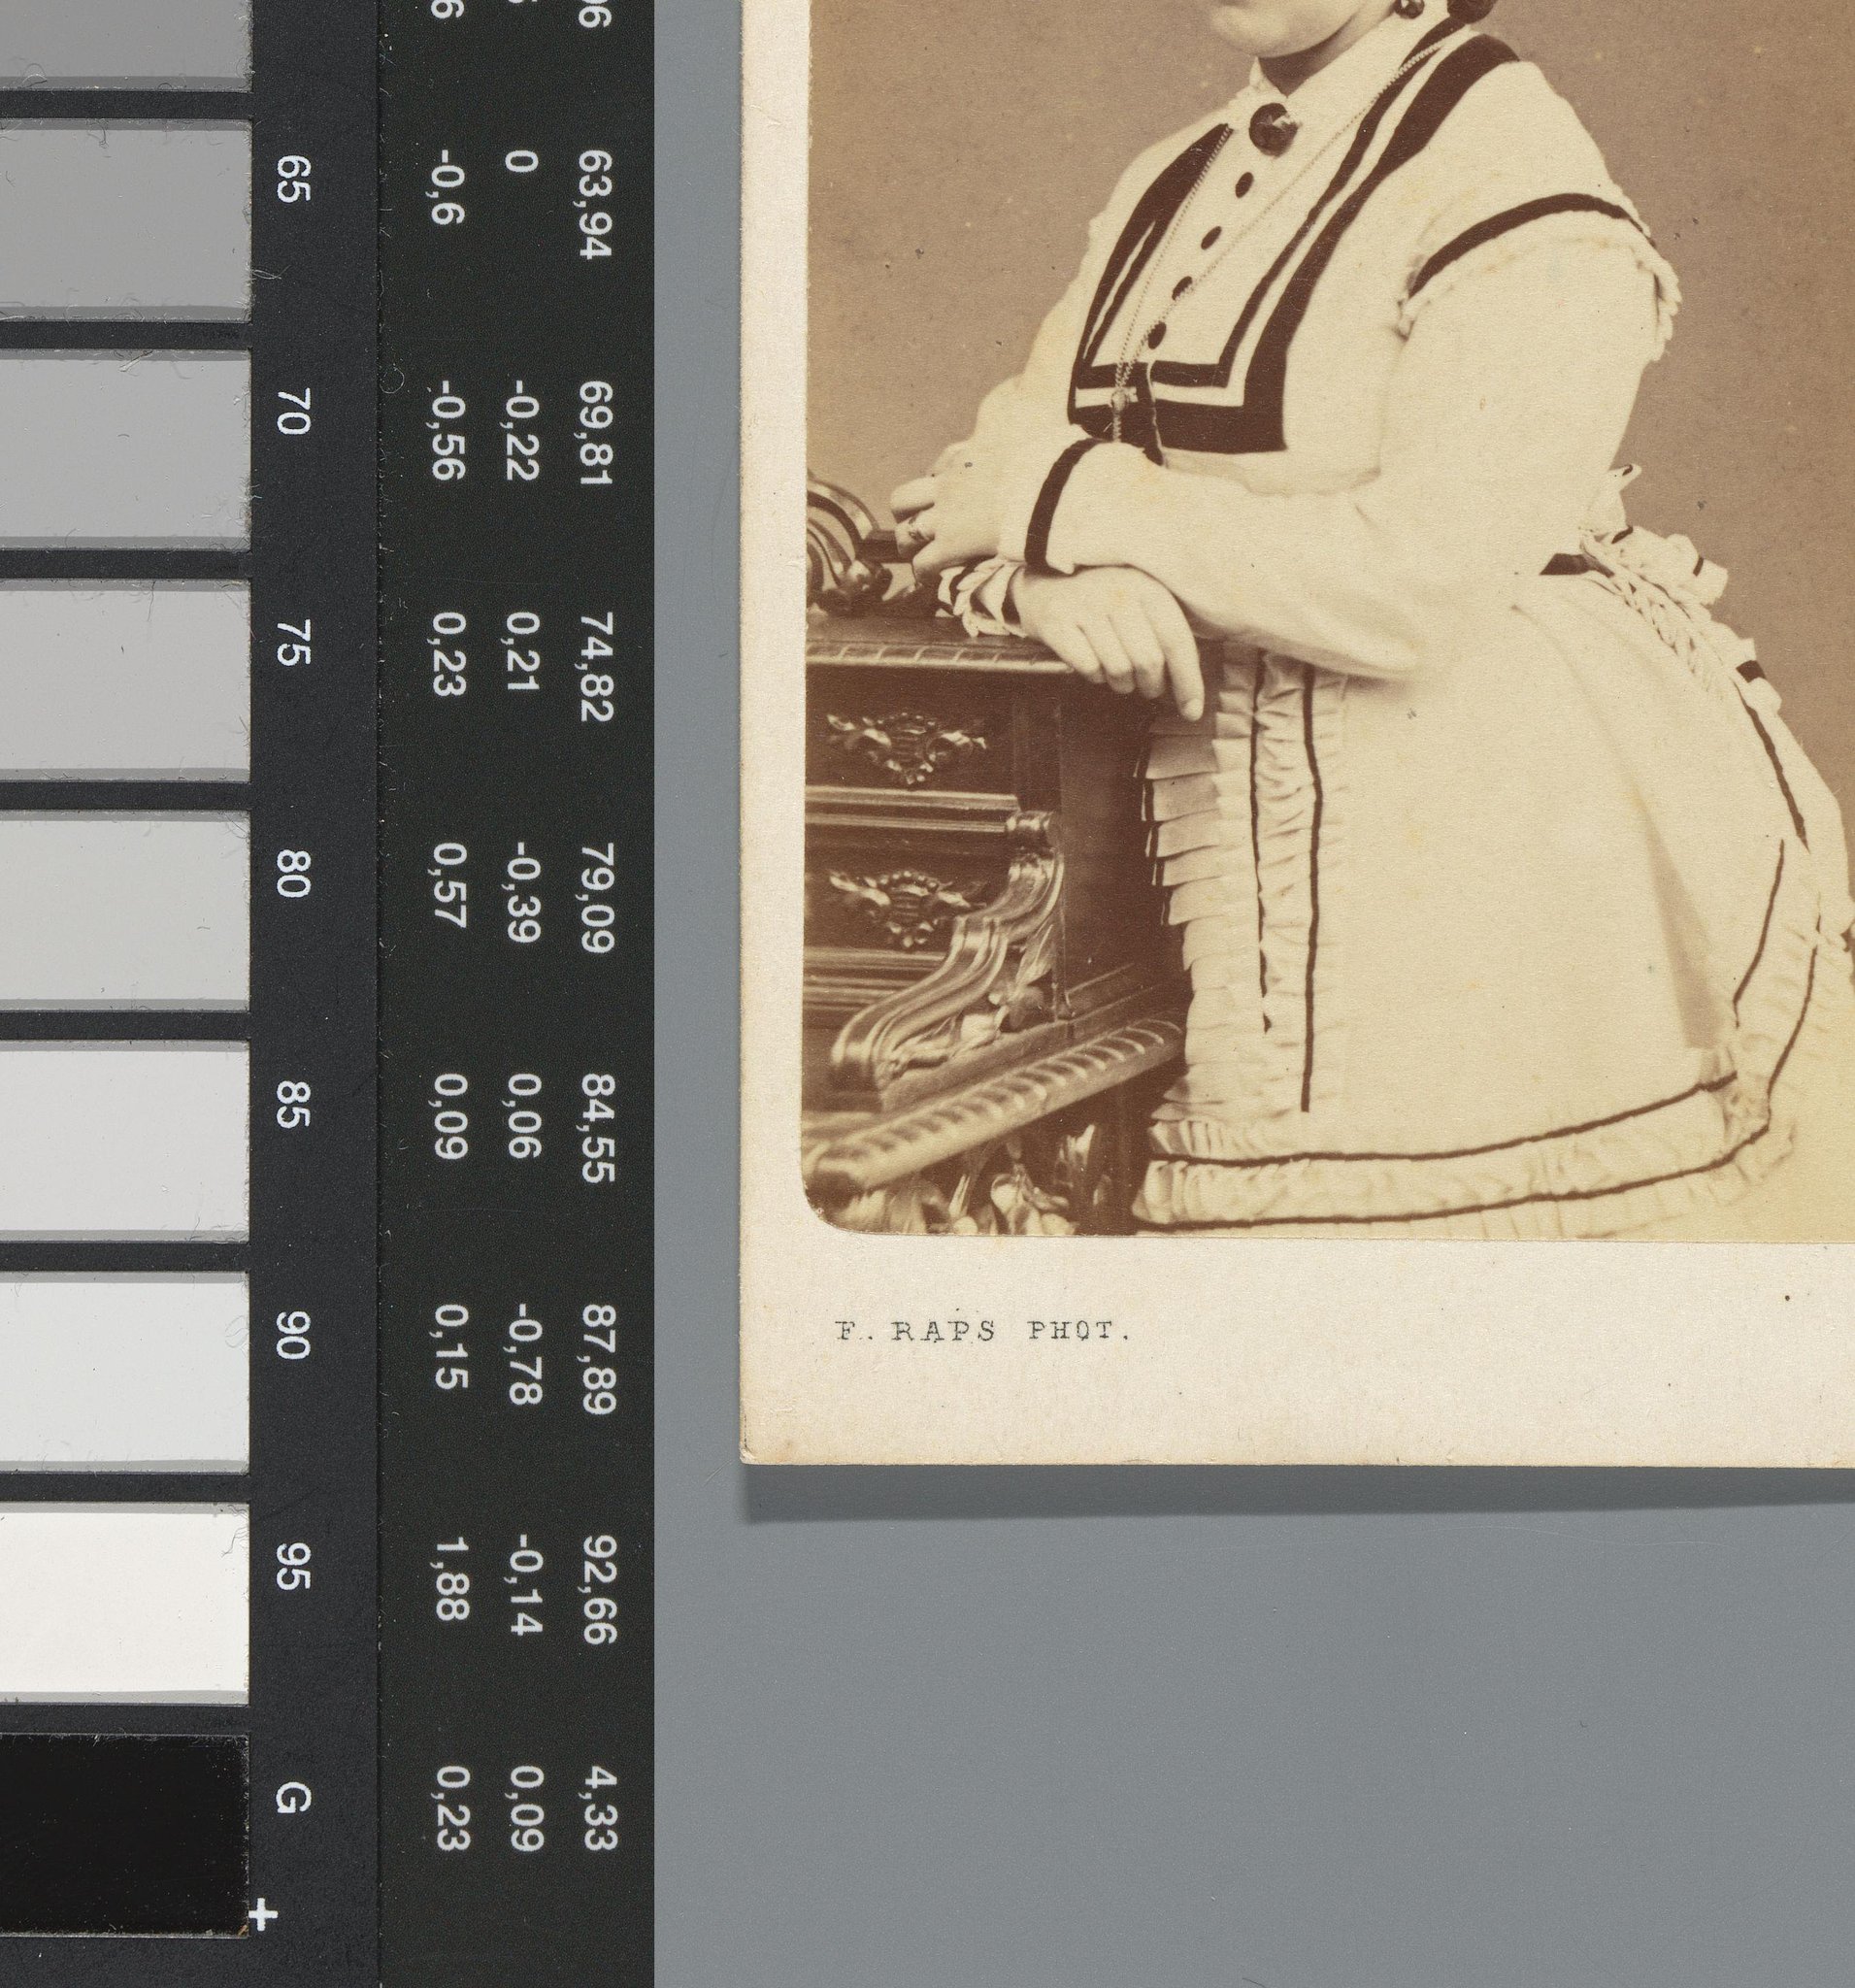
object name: carte de visite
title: Portret van Joanna Emilia Agnes van den Berg (Jeanette)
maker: friedrich raps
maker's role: fotograaf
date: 1855-1910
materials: cardboard, photographic support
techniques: albumen print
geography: cologne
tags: rotterdam, the hague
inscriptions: inscription: ‘Tante Jeannette Trip / vandenBerg / 1843-1915’, name: ‘FIRMA S. SALLINGER & Cie / F> RAPS / 16 Comödienstrasse / COELN’, name: ‘F. RAPS PHOT.’